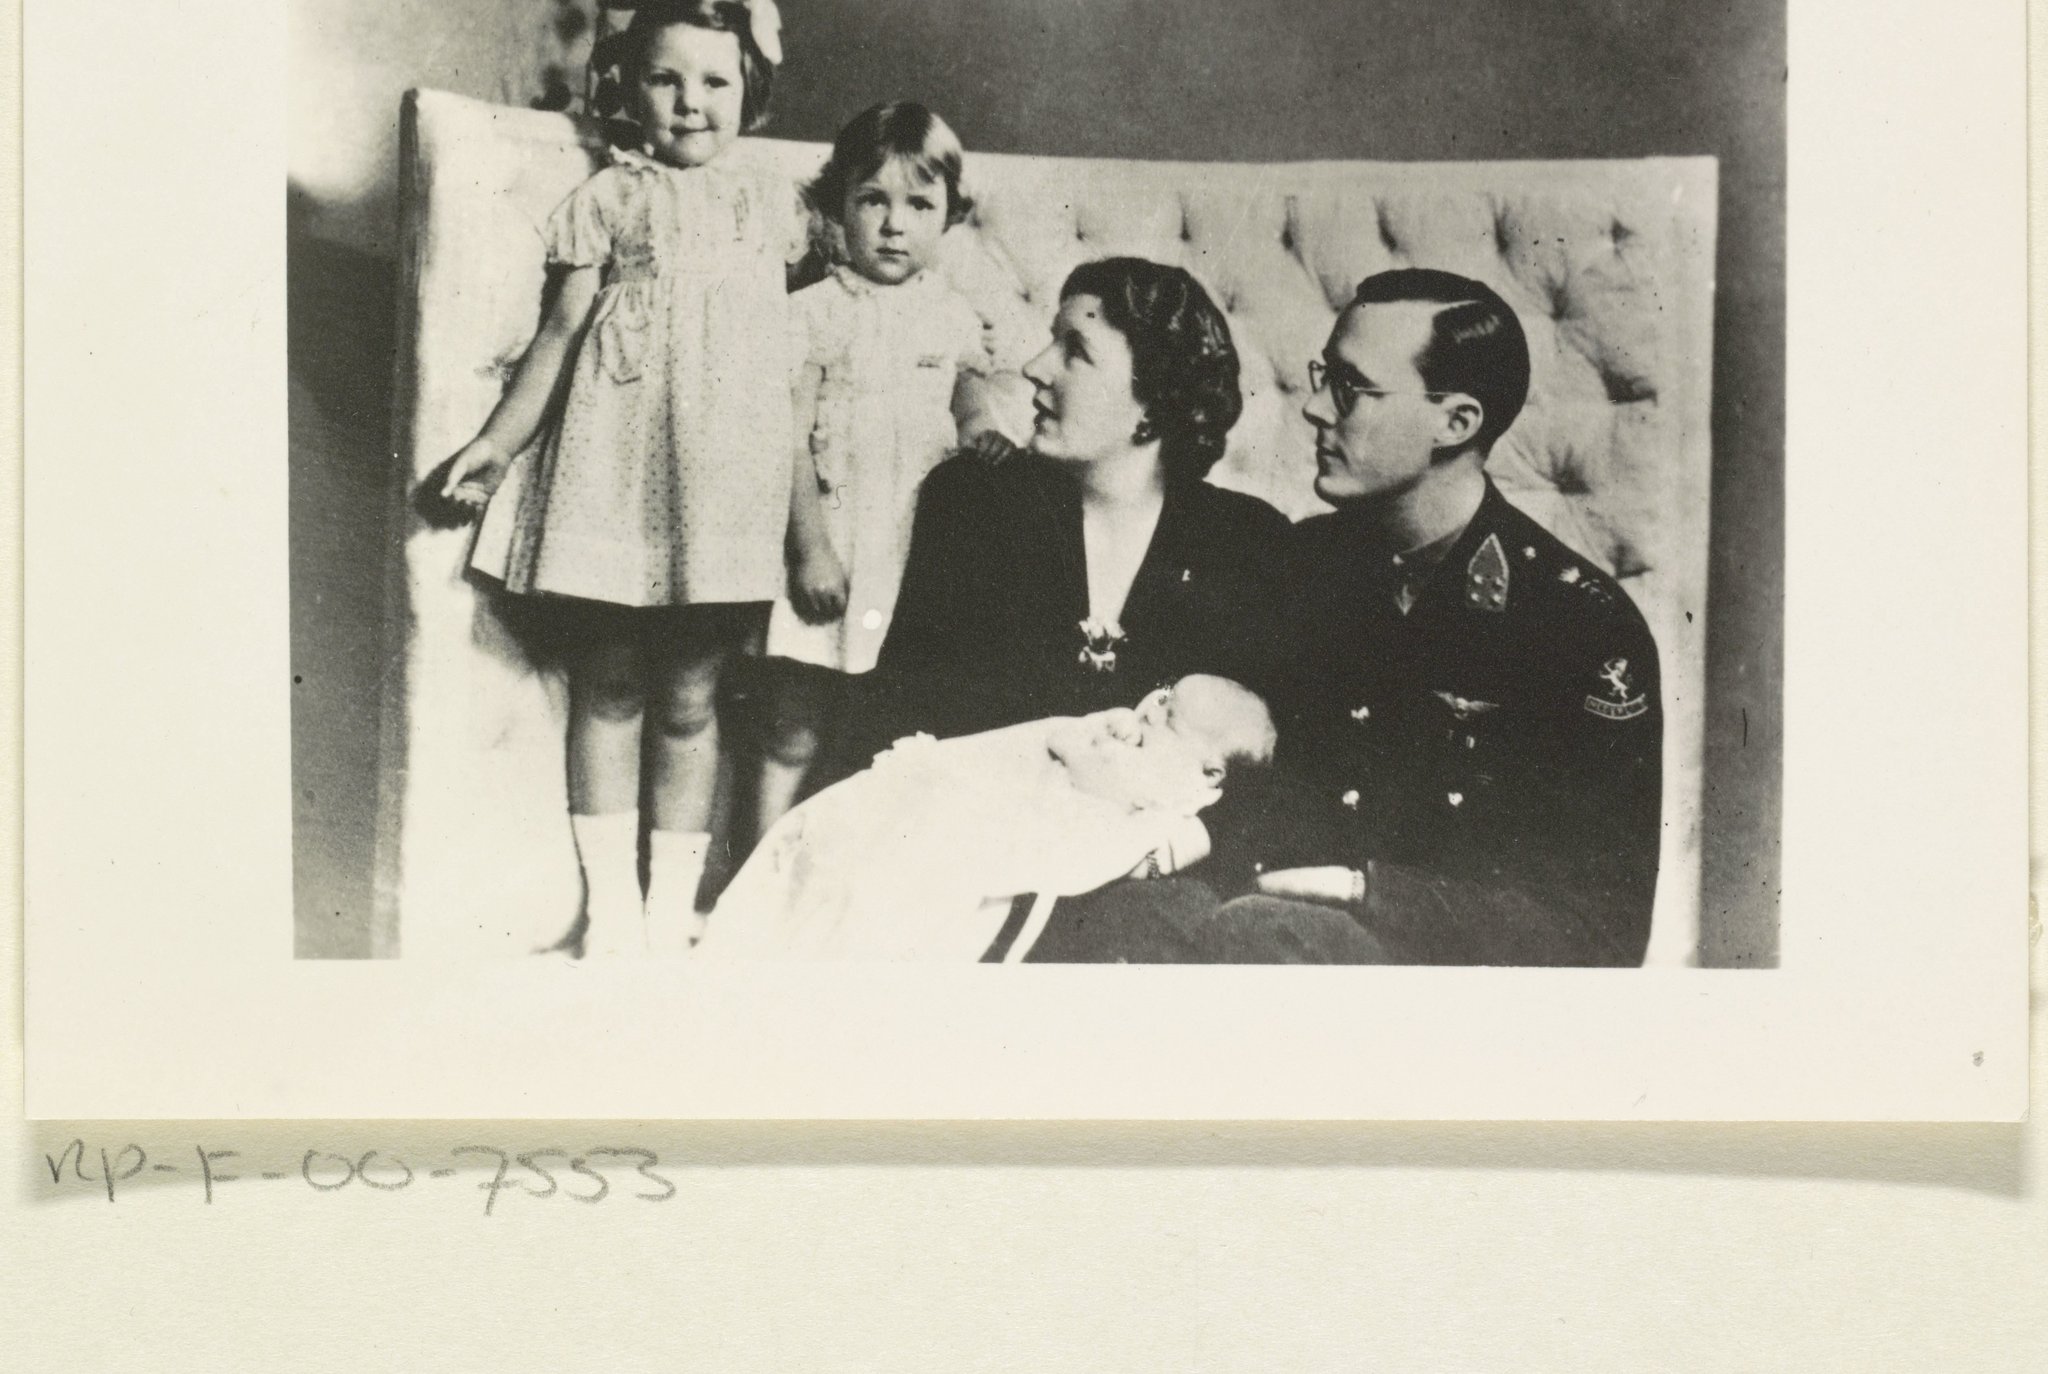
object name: photograph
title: Portret van Juliana, koningin der Nederlanden, Bernhard van Lippe-Biesterfeld, Beatrix, koningin der Nederlanden, Irene, prinses der Nederlanden, en Margriet, prinses der Nederlanden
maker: Anonymous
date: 1943-1944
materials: photographic support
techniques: photography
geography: netherlands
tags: bernhard (prins der nederlanden), beatrix (koningin der nederlanden), juliana of the netherlands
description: De hier vermelde titel verwijst naar de hoogst verkregen titel van de geportretteerde, niet per se naar de titel die de geportretteerde op deze voorstelling draagt.